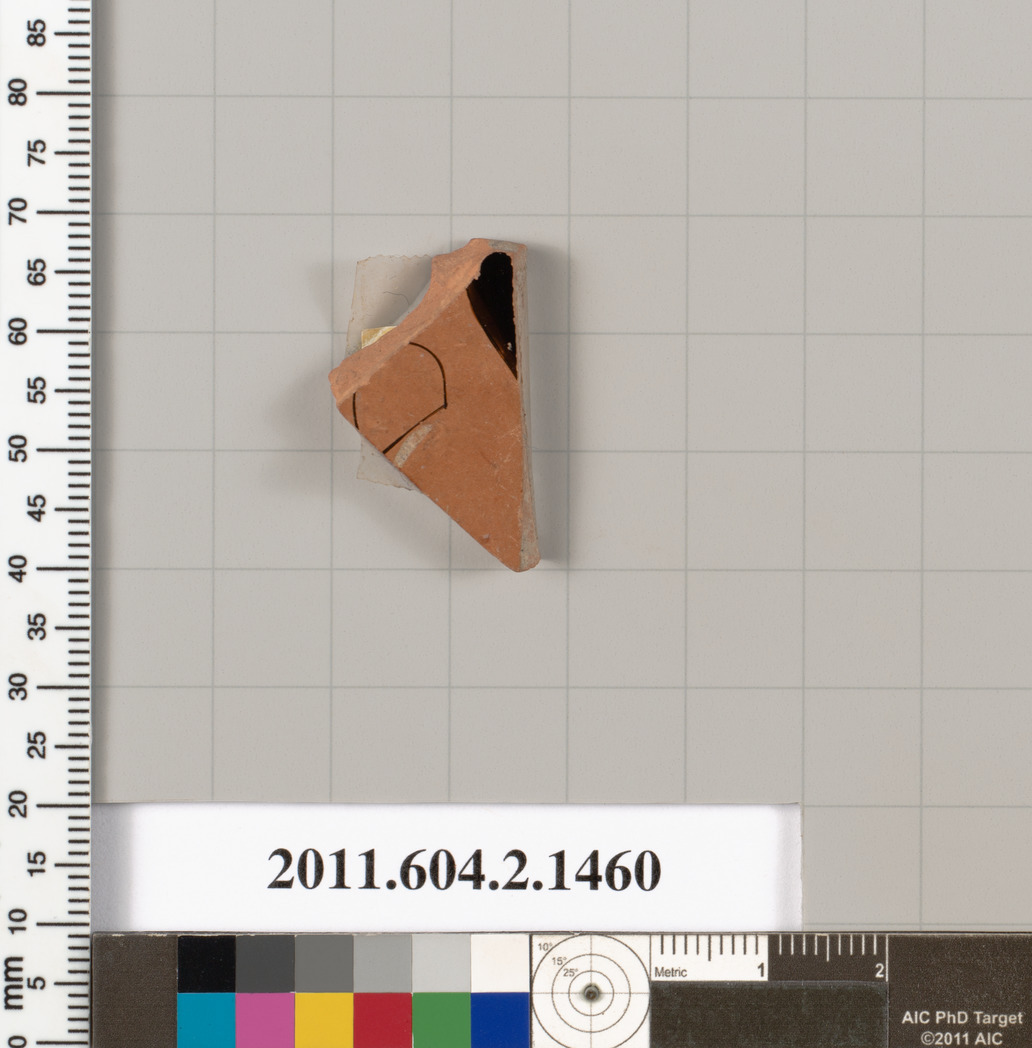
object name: skyphos fragment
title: Terracotta fragment of a skyphos (deep drinking cup)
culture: greek, attic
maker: makron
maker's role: artist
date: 490-470 BCE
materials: terracotta